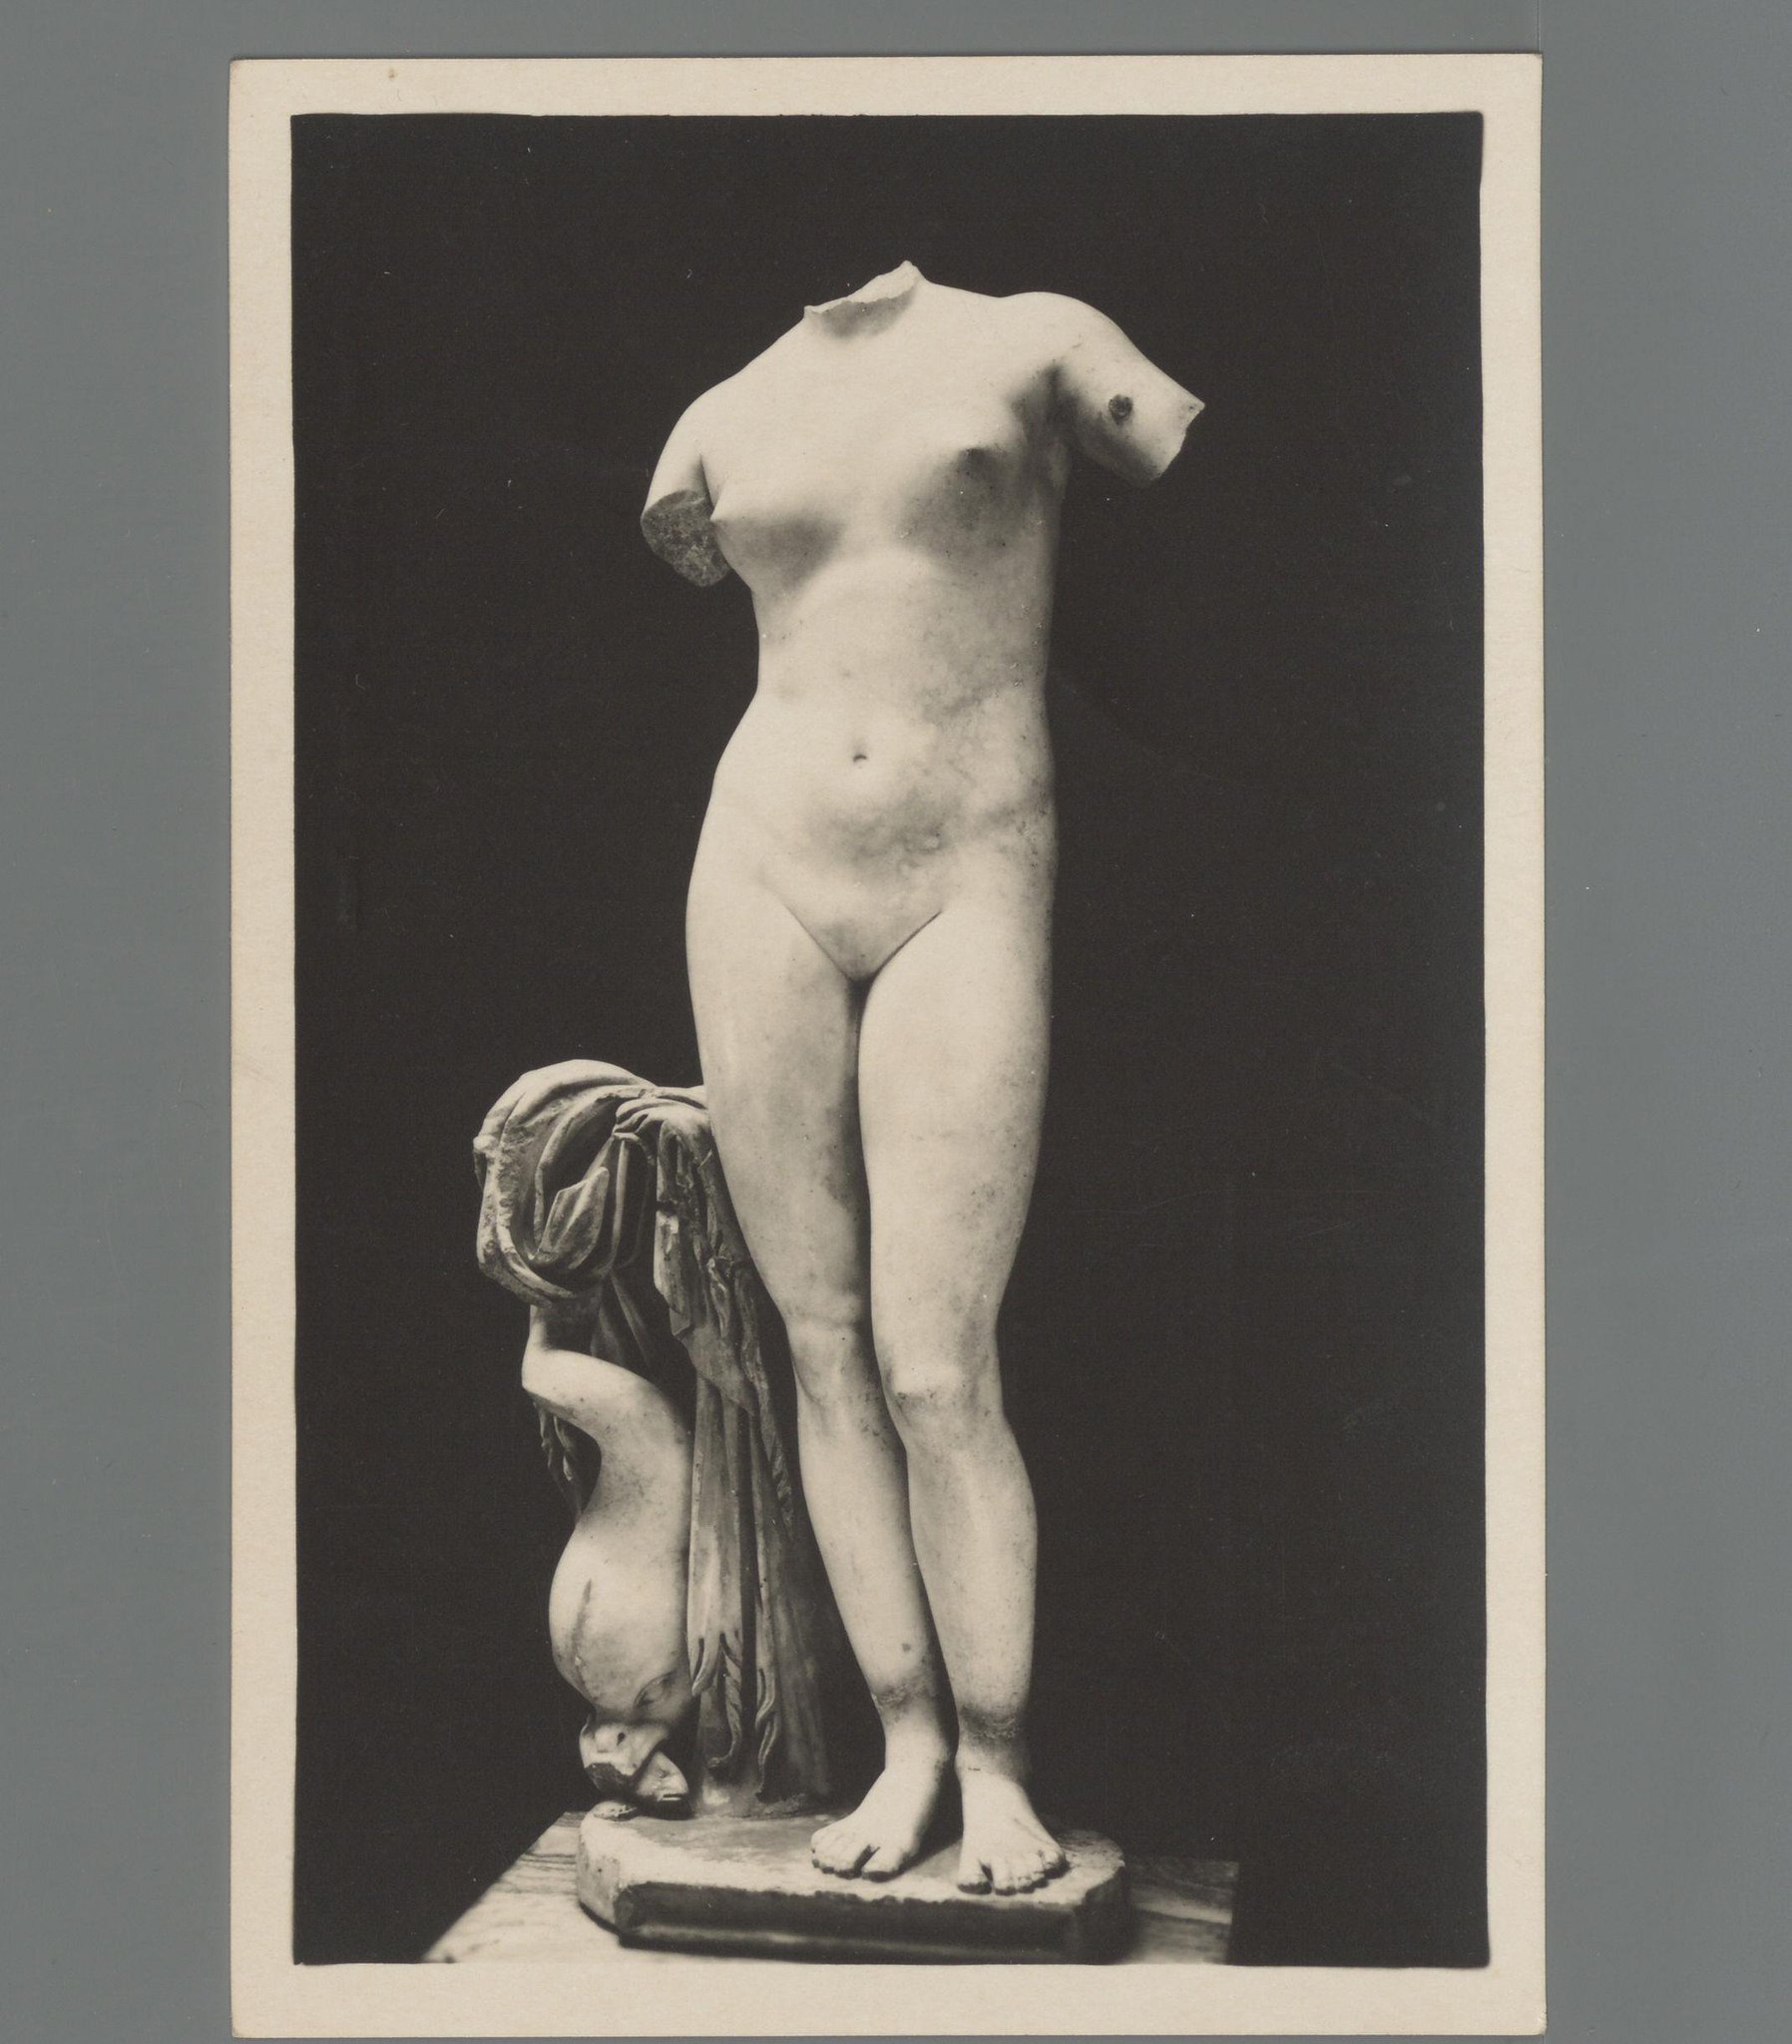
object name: photograph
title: Roma - Museo Nazionale - La Venere di Cirene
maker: Anonymous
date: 1906-1930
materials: paper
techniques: gelatin silver print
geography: rome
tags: statues, paintings, etc. ~ objects of worship in roman religion, permanent exhibition, museum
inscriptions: collector's mark: ‘AFE v S’